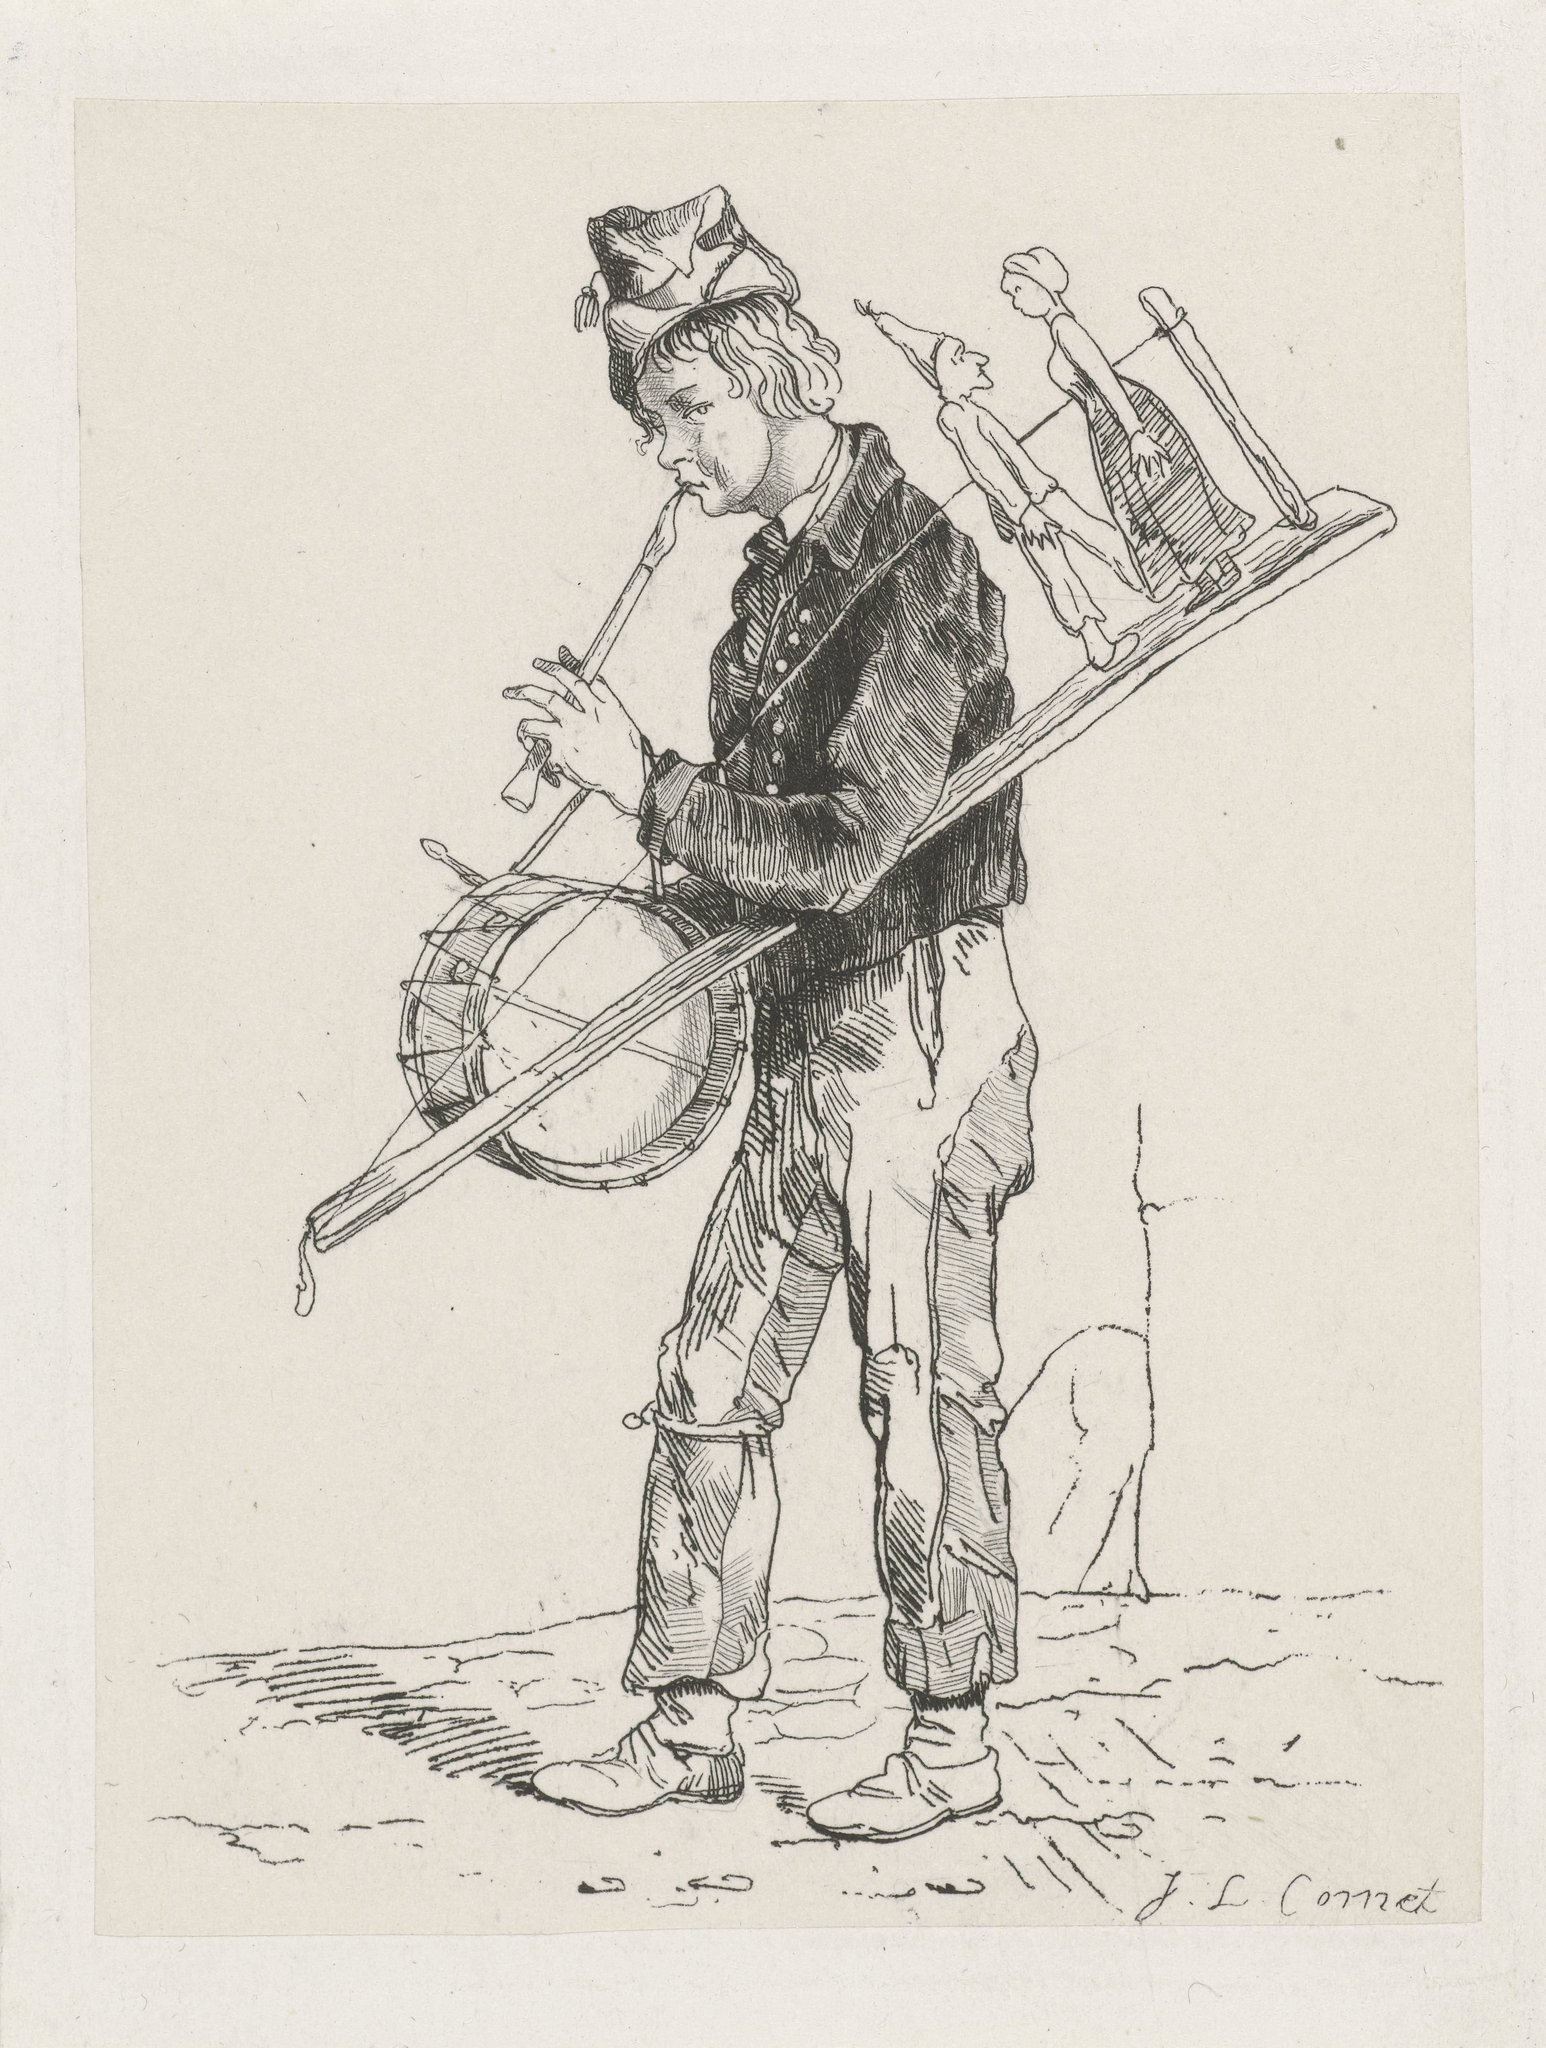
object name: print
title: Eenmansorkest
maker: jacobus ludovicus cornet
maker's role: draughtsman, print maker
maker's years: 1815-1882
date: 1825-1882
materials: paper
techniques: etching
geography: leiden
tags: popular music, street music, one person playing several instruments, one-man band - cc - out of doors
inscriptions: collector's mark: Lugt 2228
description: Een straatmuzikant speelt fluit en heeft een constructie vast waardoor hij zowel op een trom kan slaan als een snaarinstrument kan bespelen.